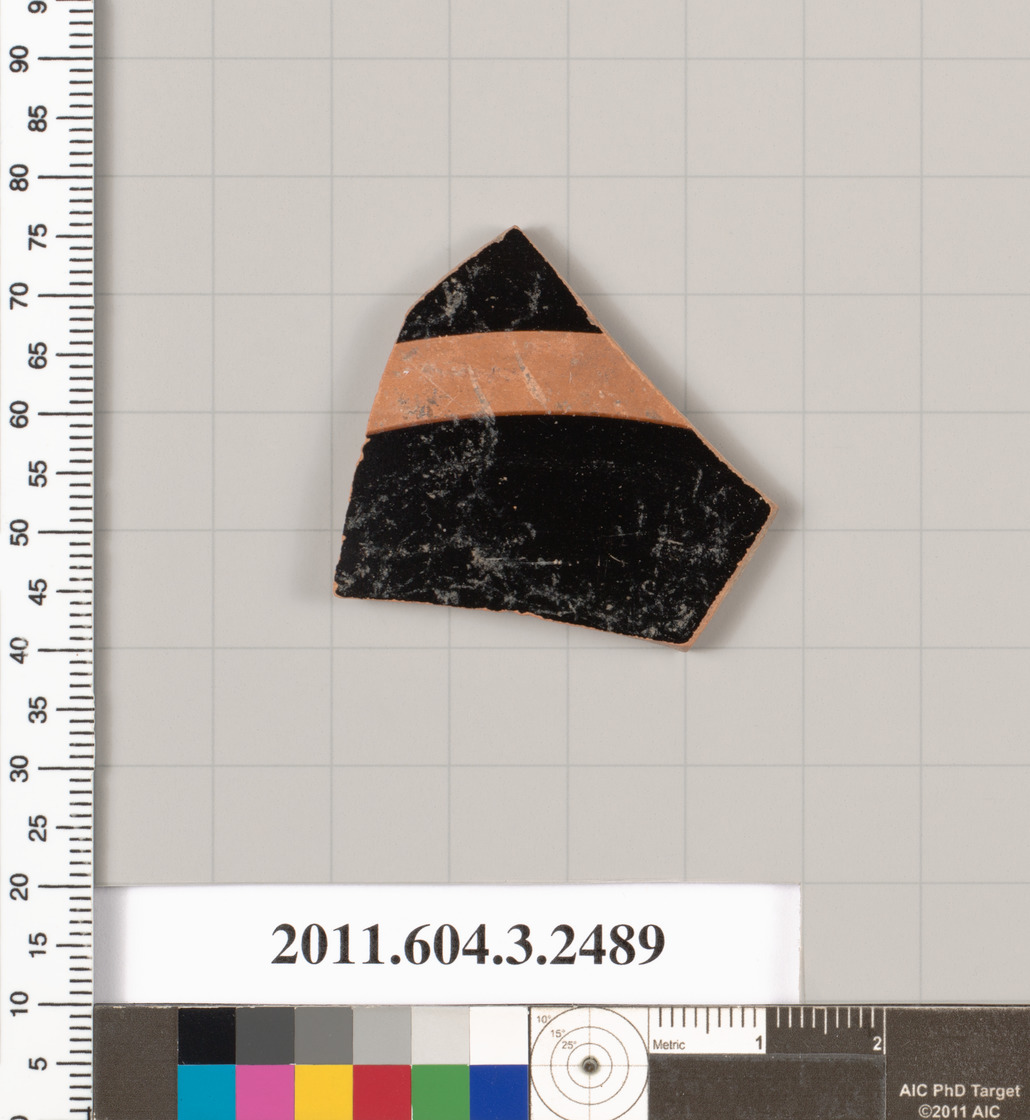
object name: kylix fragment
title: Terracotta fragment of a kylix (drinking cup)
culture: greek, attic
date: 600-401 BCE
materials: terracotta